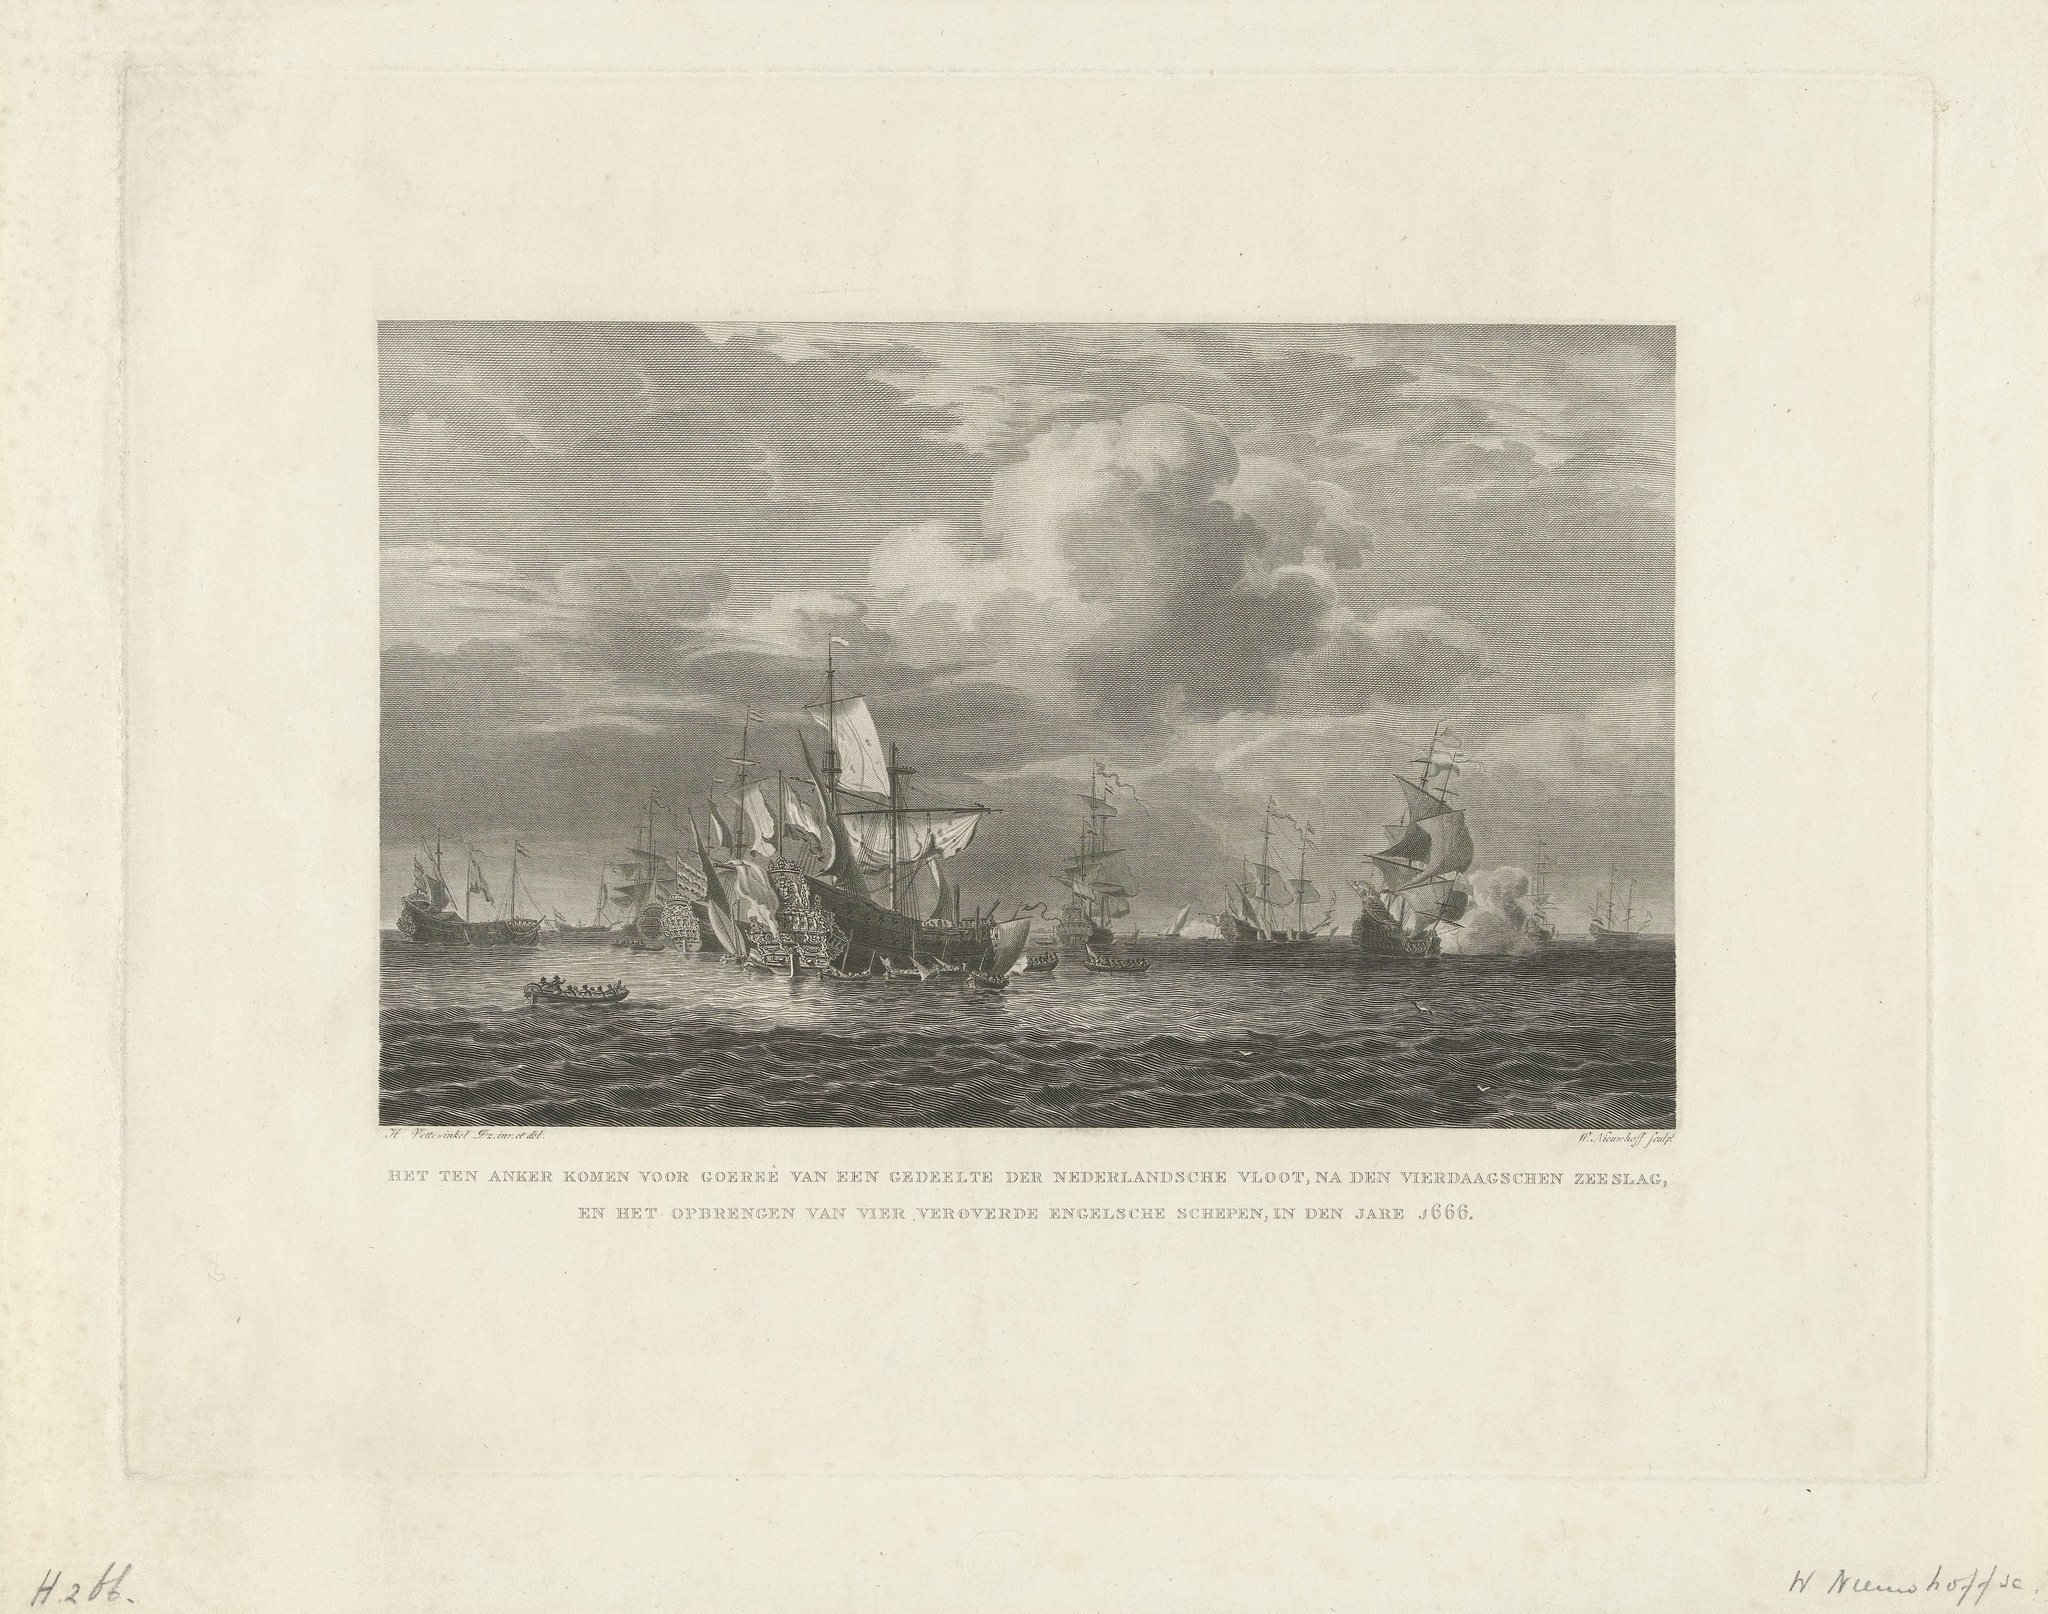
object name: print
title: Nederlandse vloot voor Goeree na de Vierdaagse Zeeslag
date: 1800-1837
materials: paper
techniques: engraving, etching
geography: amsterdam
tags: damage (to a ship), battle (+ naval force)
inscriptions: collector's mark, collector's mark: Lugt 2760, collector's mark: Lugt 2228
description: Een deel van de Nederlandse vloot komt aan voor Goeree na de Vierdaagse Zeeslag in 1666, die onderdeel was van de Tweede Engelse Zeeoorlog. Daarbij zijn ook vier buitgemaakte Engelse schepen.